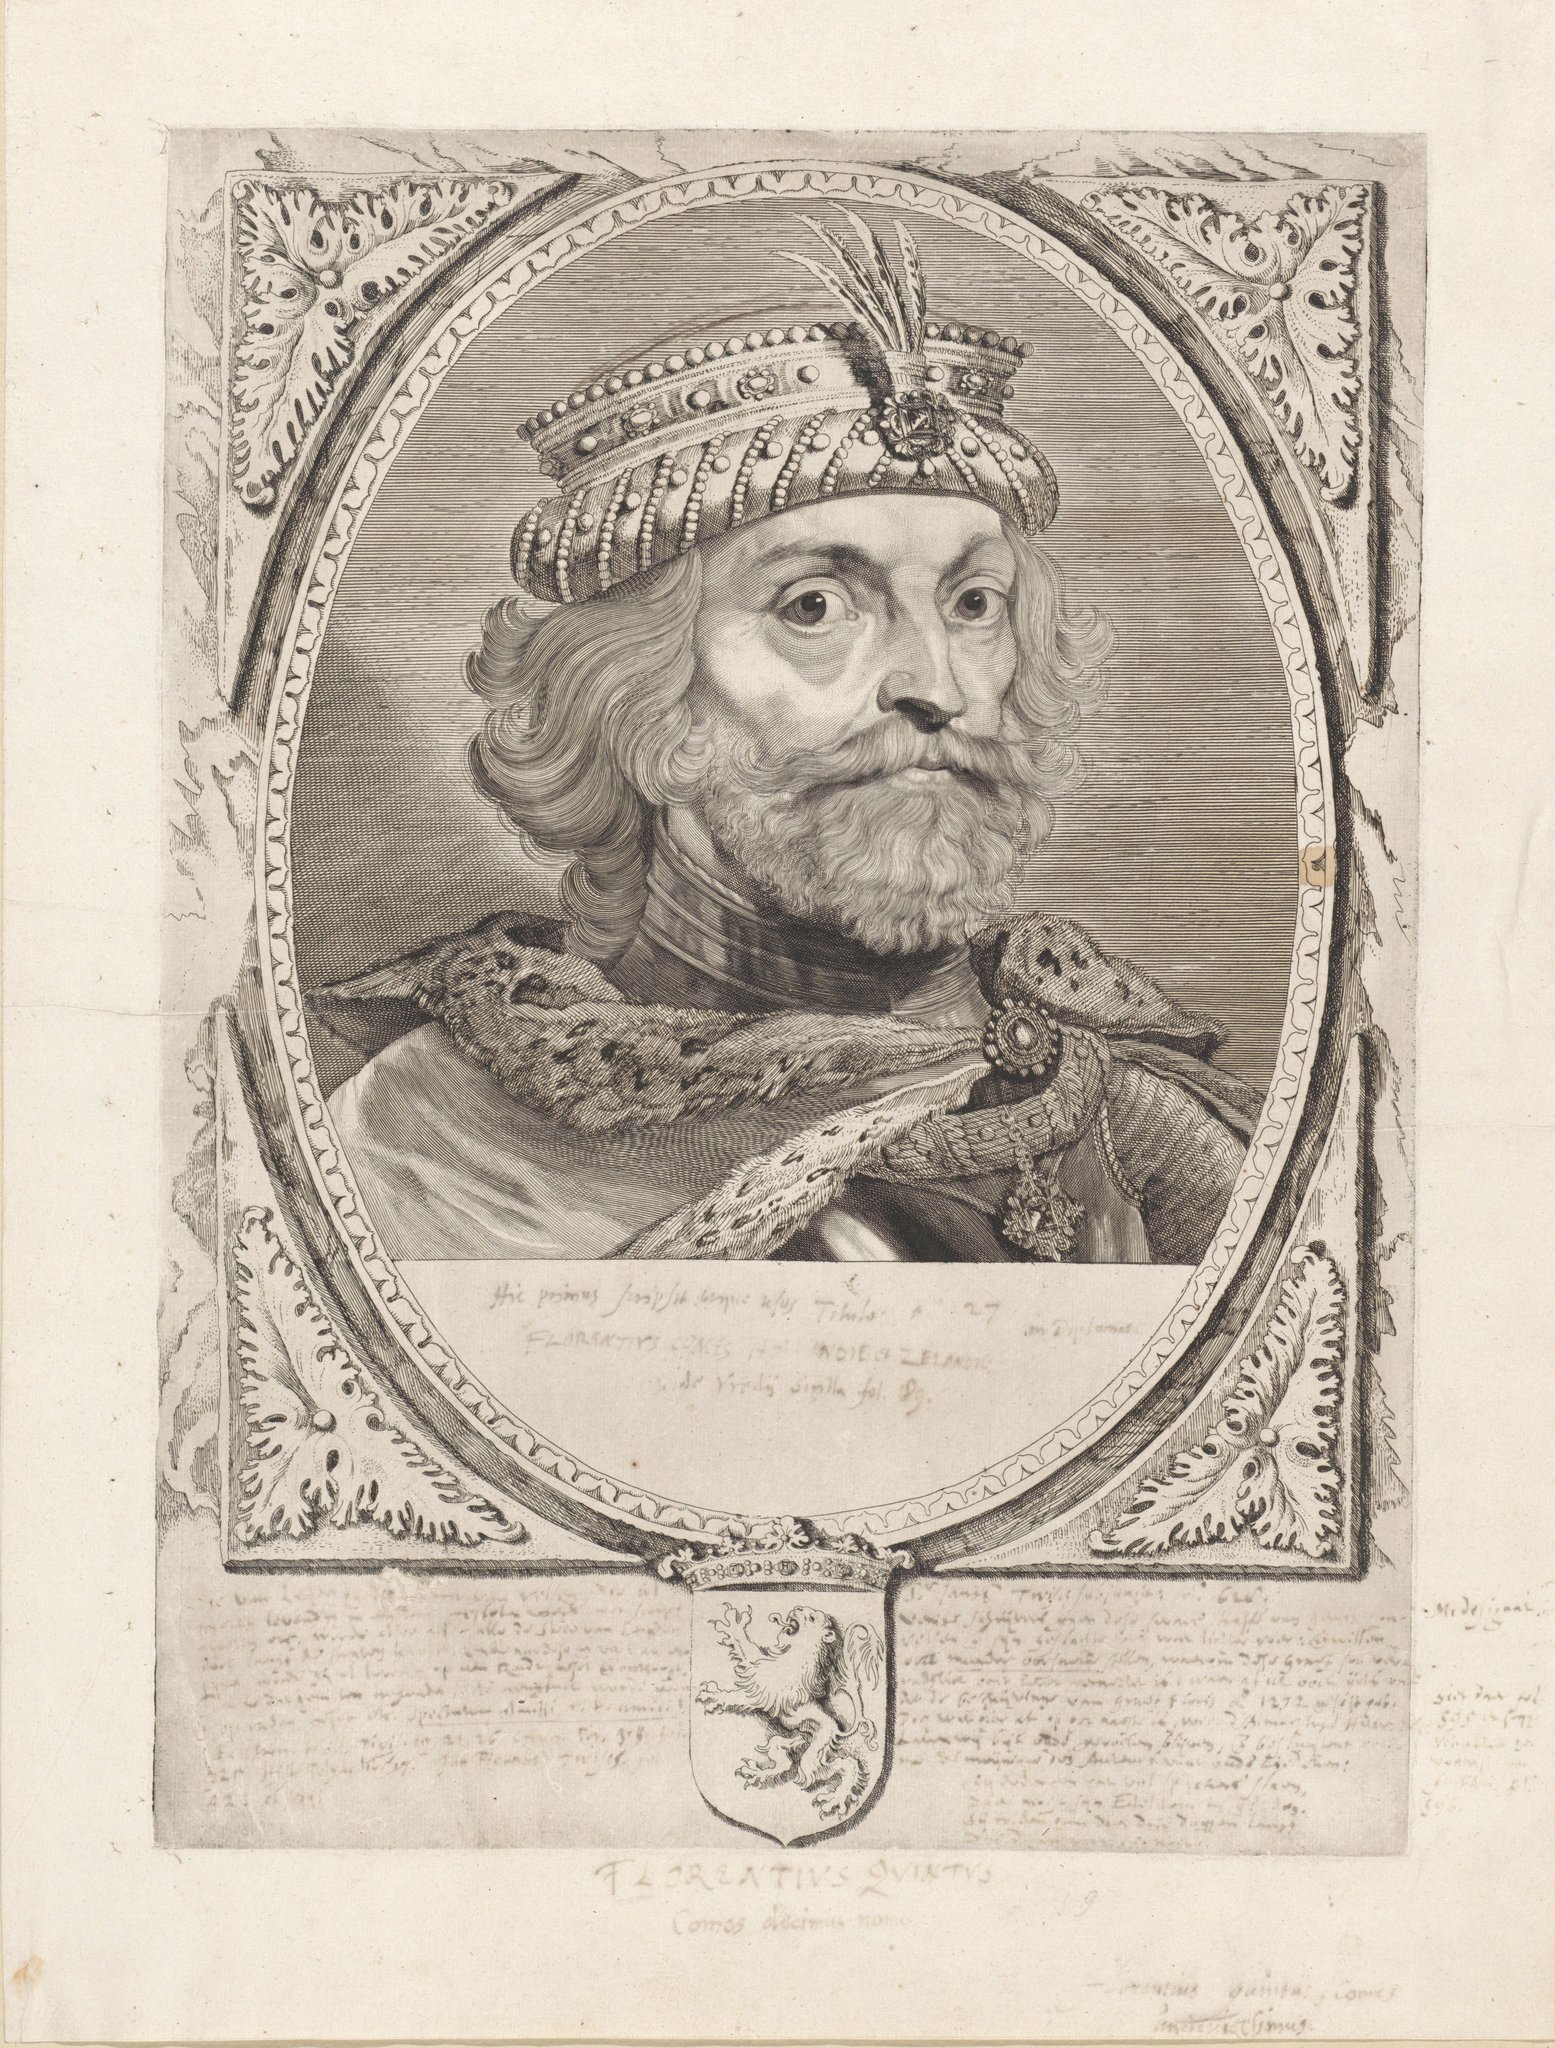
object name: print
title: Portret van Floris V, graaf van Holland en Zeeland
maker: cornelis visscher (ii)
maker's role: draughtsman, painter, print maker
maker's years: 1628-1658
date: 1650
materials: paper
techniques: engraving, etching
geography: haarlem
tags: leiden, floris v (graaf van holland en zeeland), head-gear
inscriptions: inscription, collector's mark: Lugt 240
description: Floris V, graaf van Holland en Zeeland, met een met veren, edelstenen en parels verfraaide hoofddeksel. De omlijsting is versierd met het wapen van Holland.